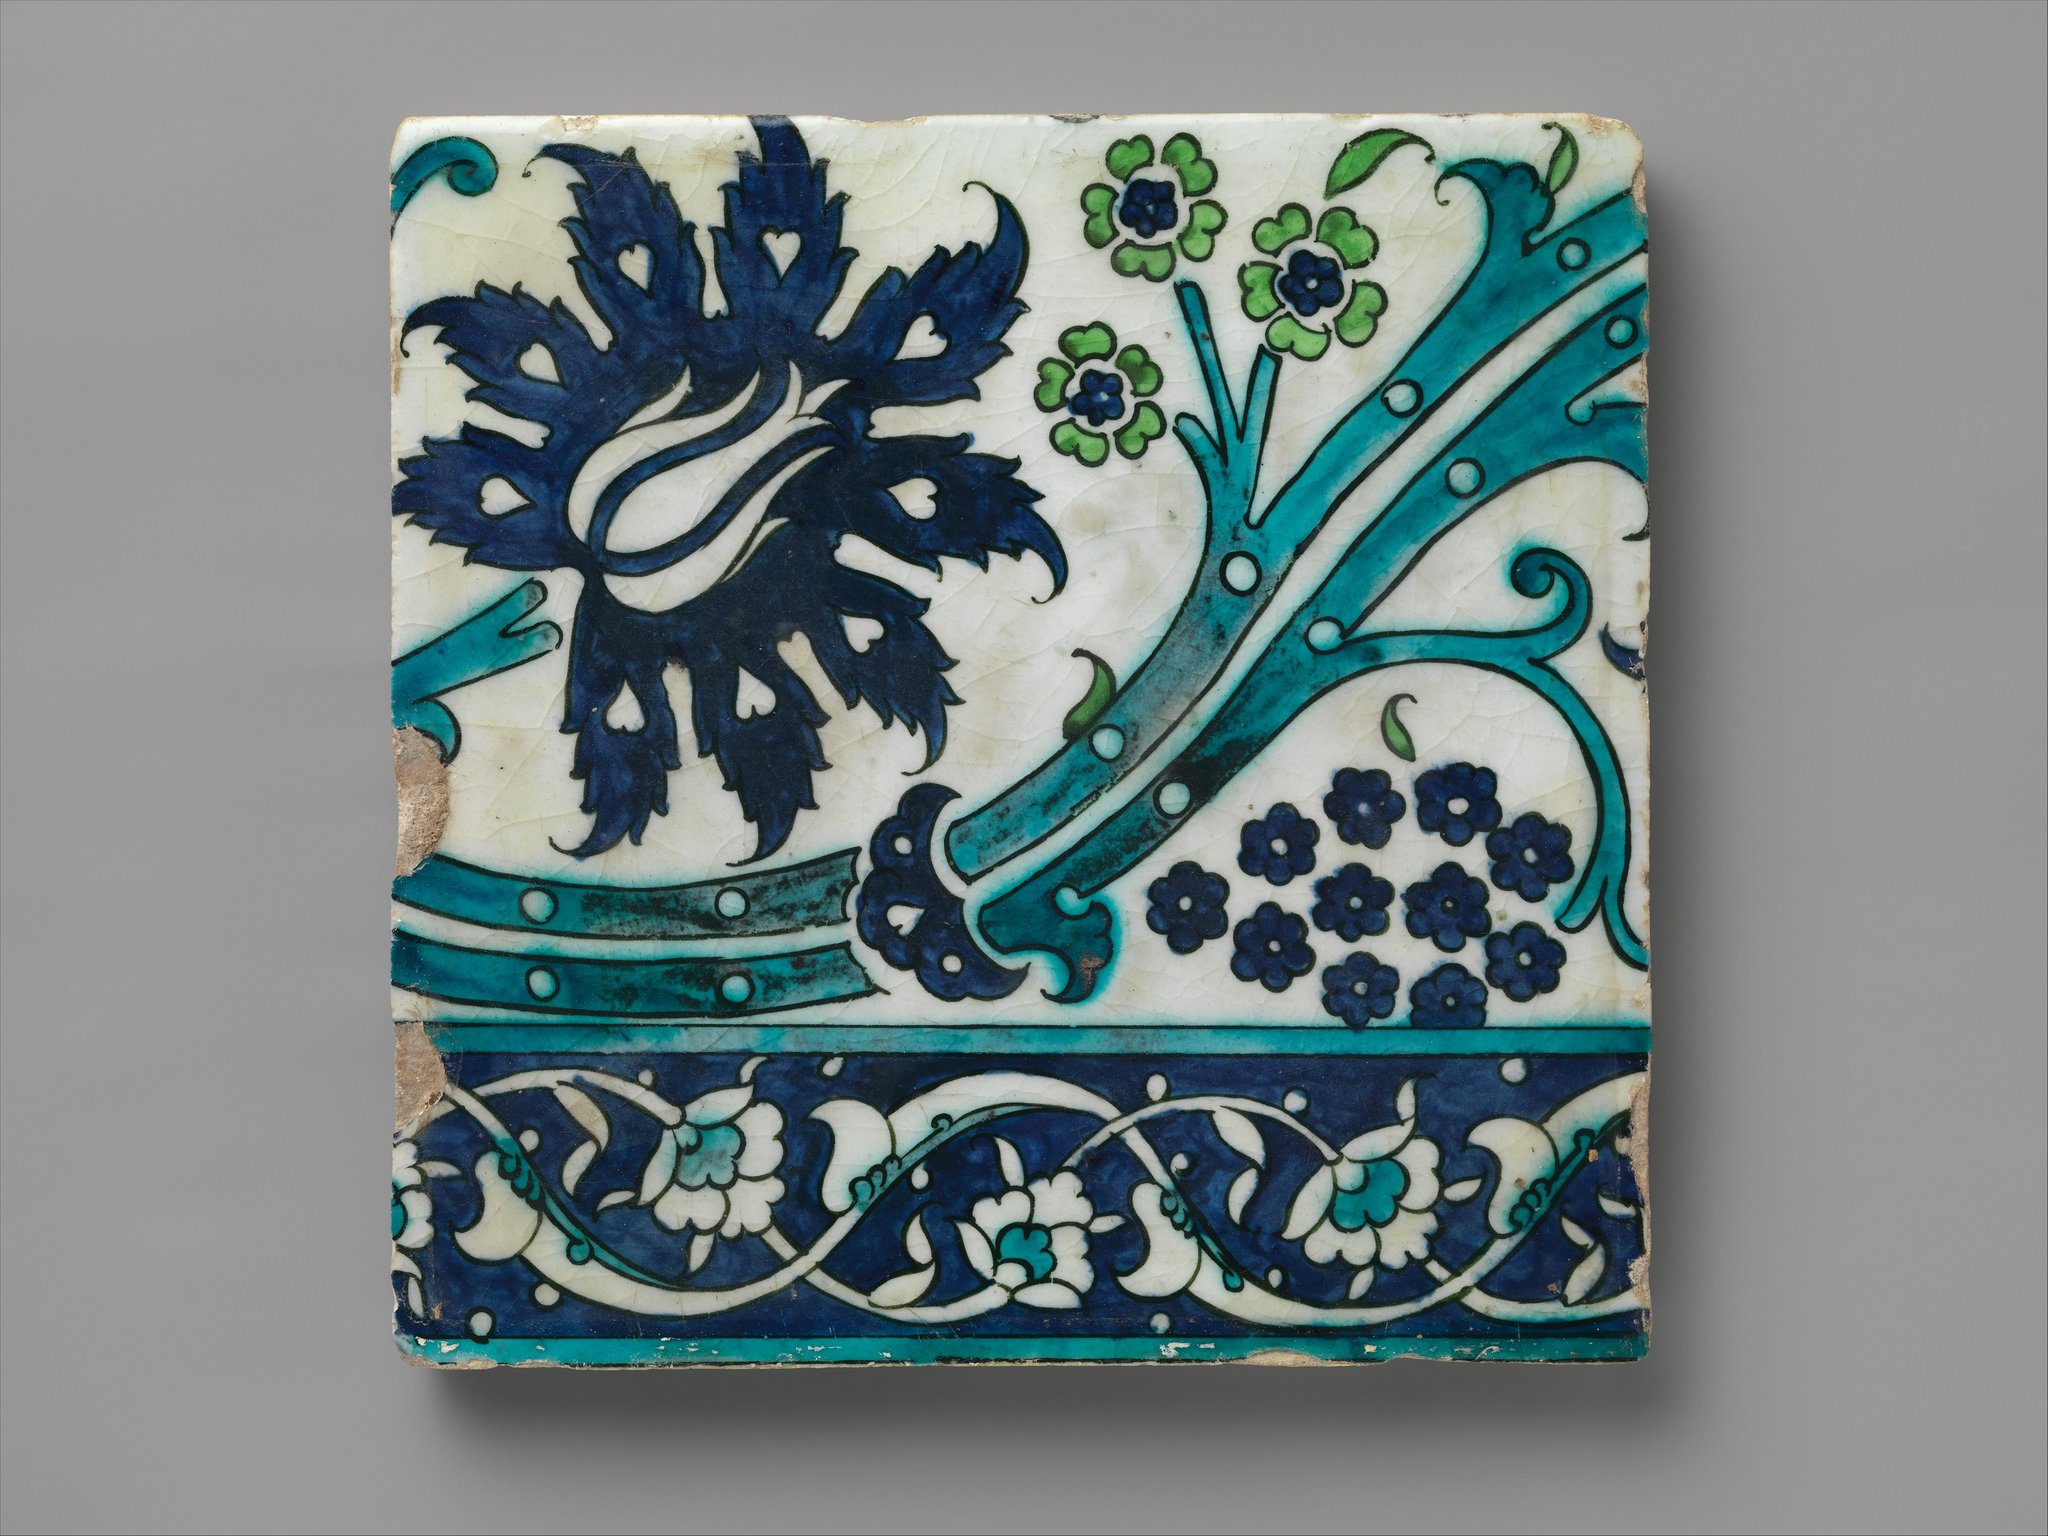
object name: tile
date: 1551-1600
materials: glaze, stonepaste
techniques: painting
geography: syria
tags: flowers